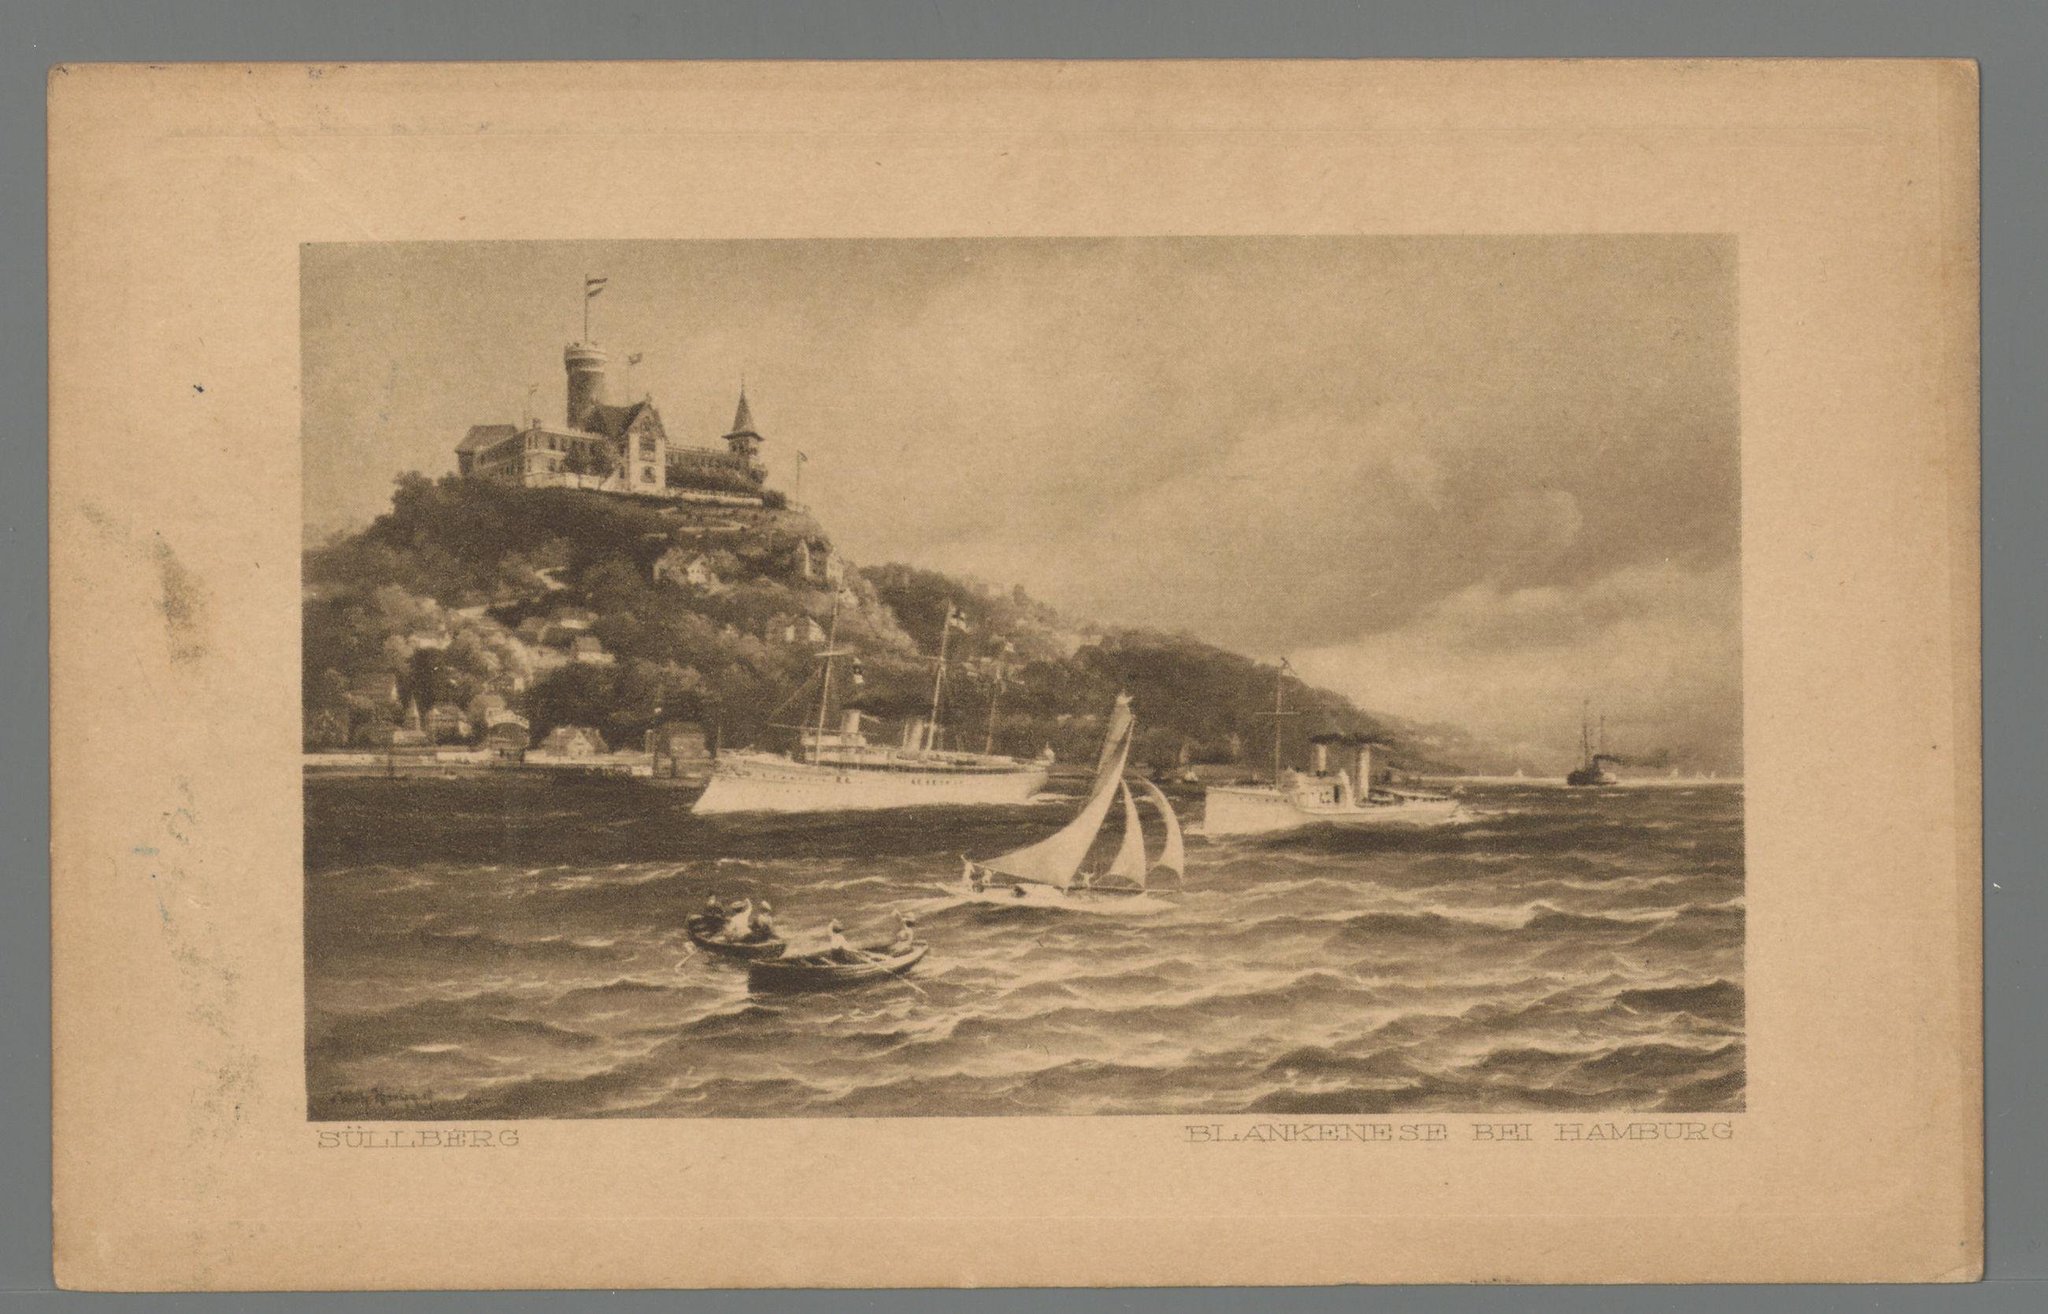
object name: ansichtkaart, prentbriefkaart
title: Süllberg. Blankenese bei Hamburg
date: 1905-1913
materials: cardboard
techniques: rotogravure, writing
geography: hamburg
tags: city-view, and landscape with man-made constructions, canals, waters (in city)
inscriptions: postage stamp